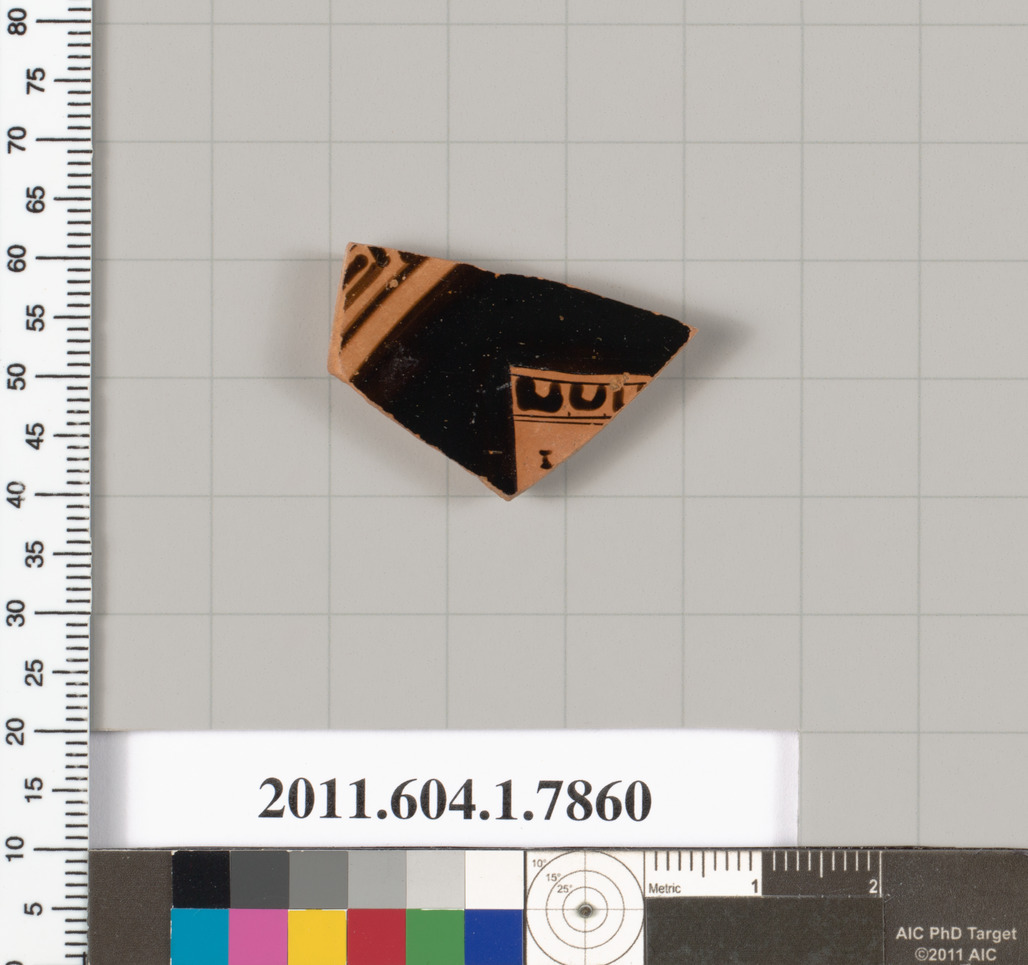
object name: kylix fragment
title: Terracotta fragment of a kylix (drinking cup)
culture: greek, attic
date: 475-451 BCE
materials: terracotta